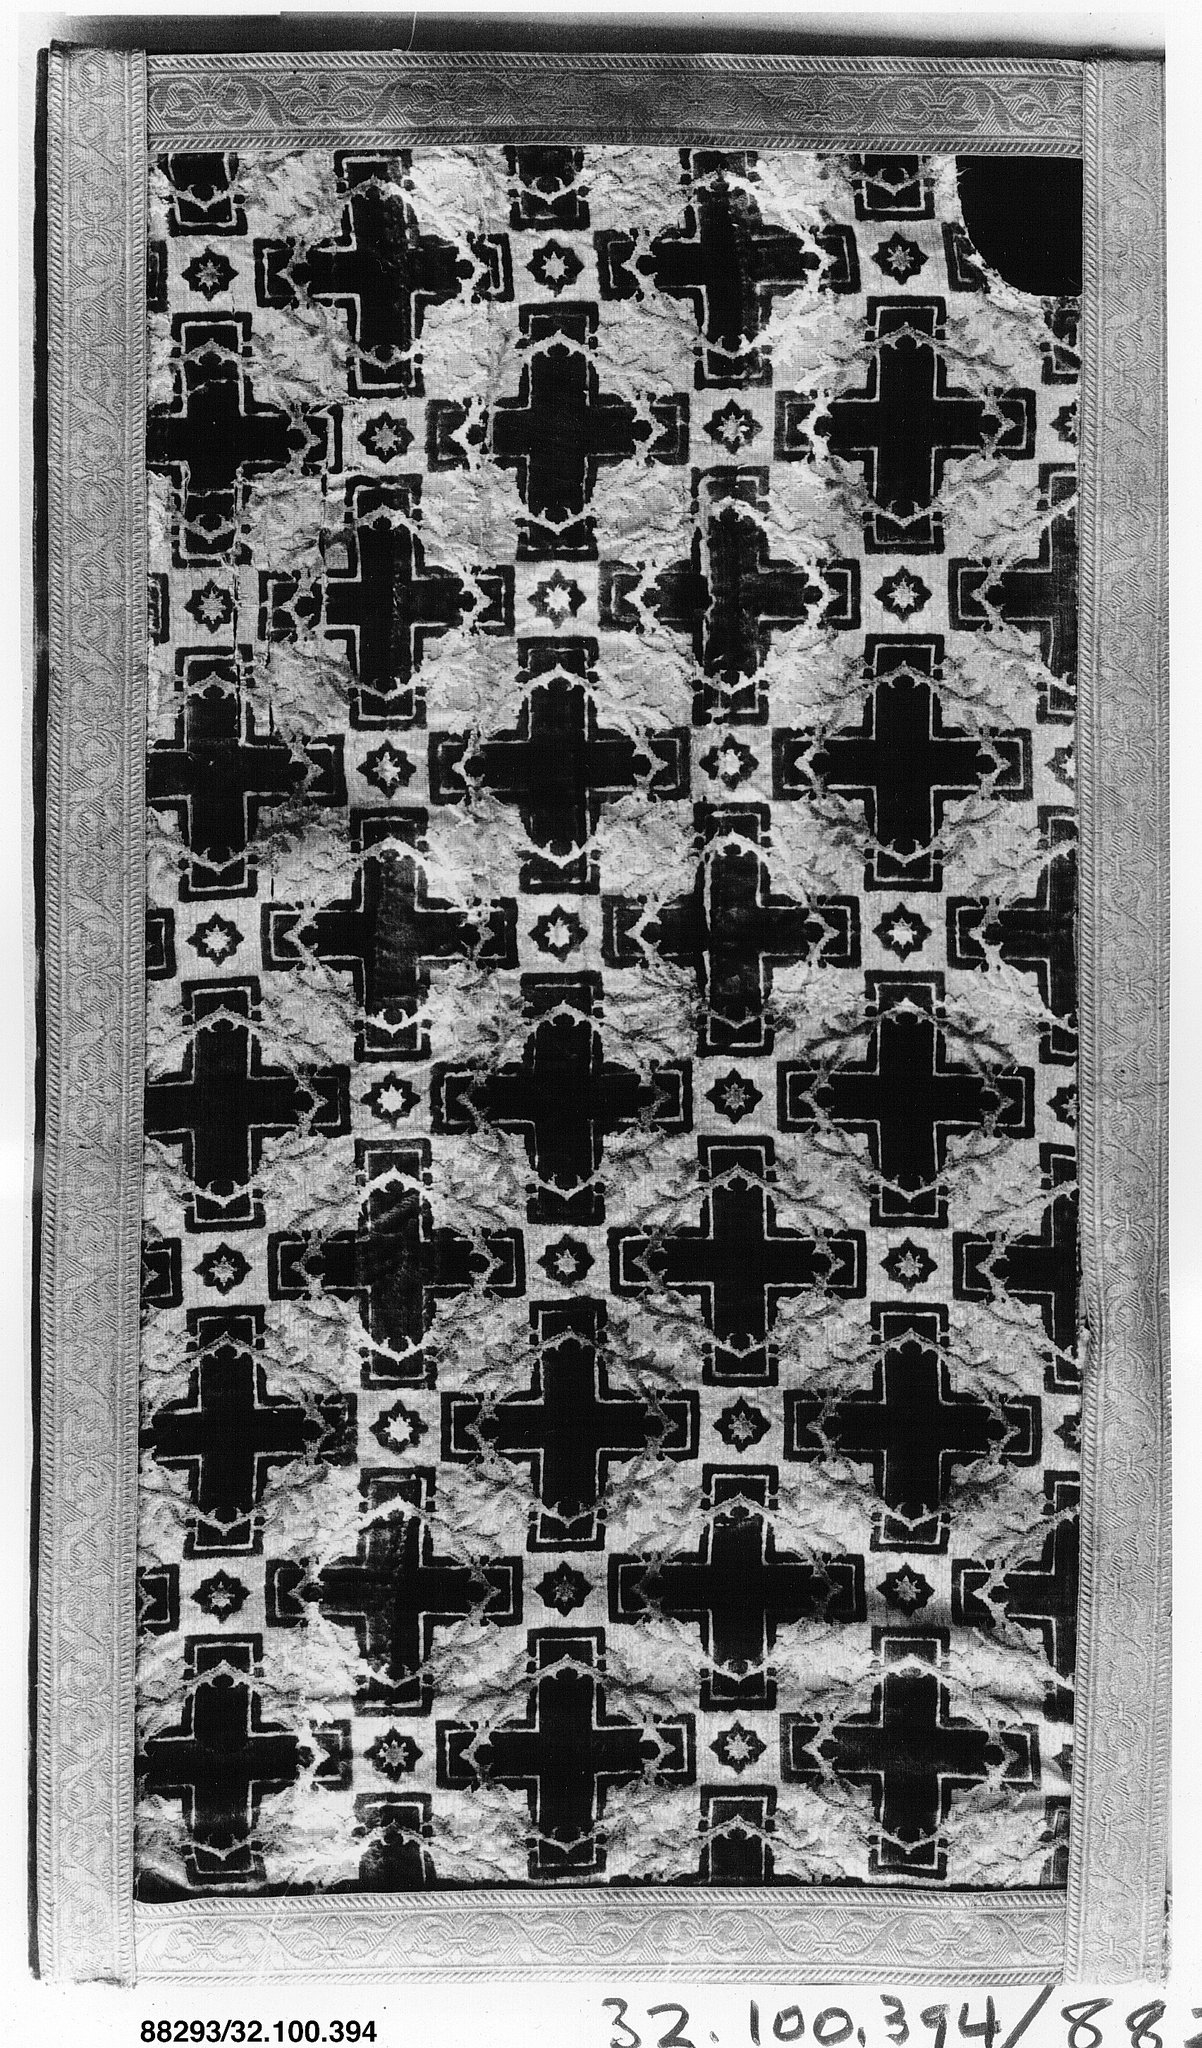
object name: fragment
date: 1801-1833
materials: metal thread, silk